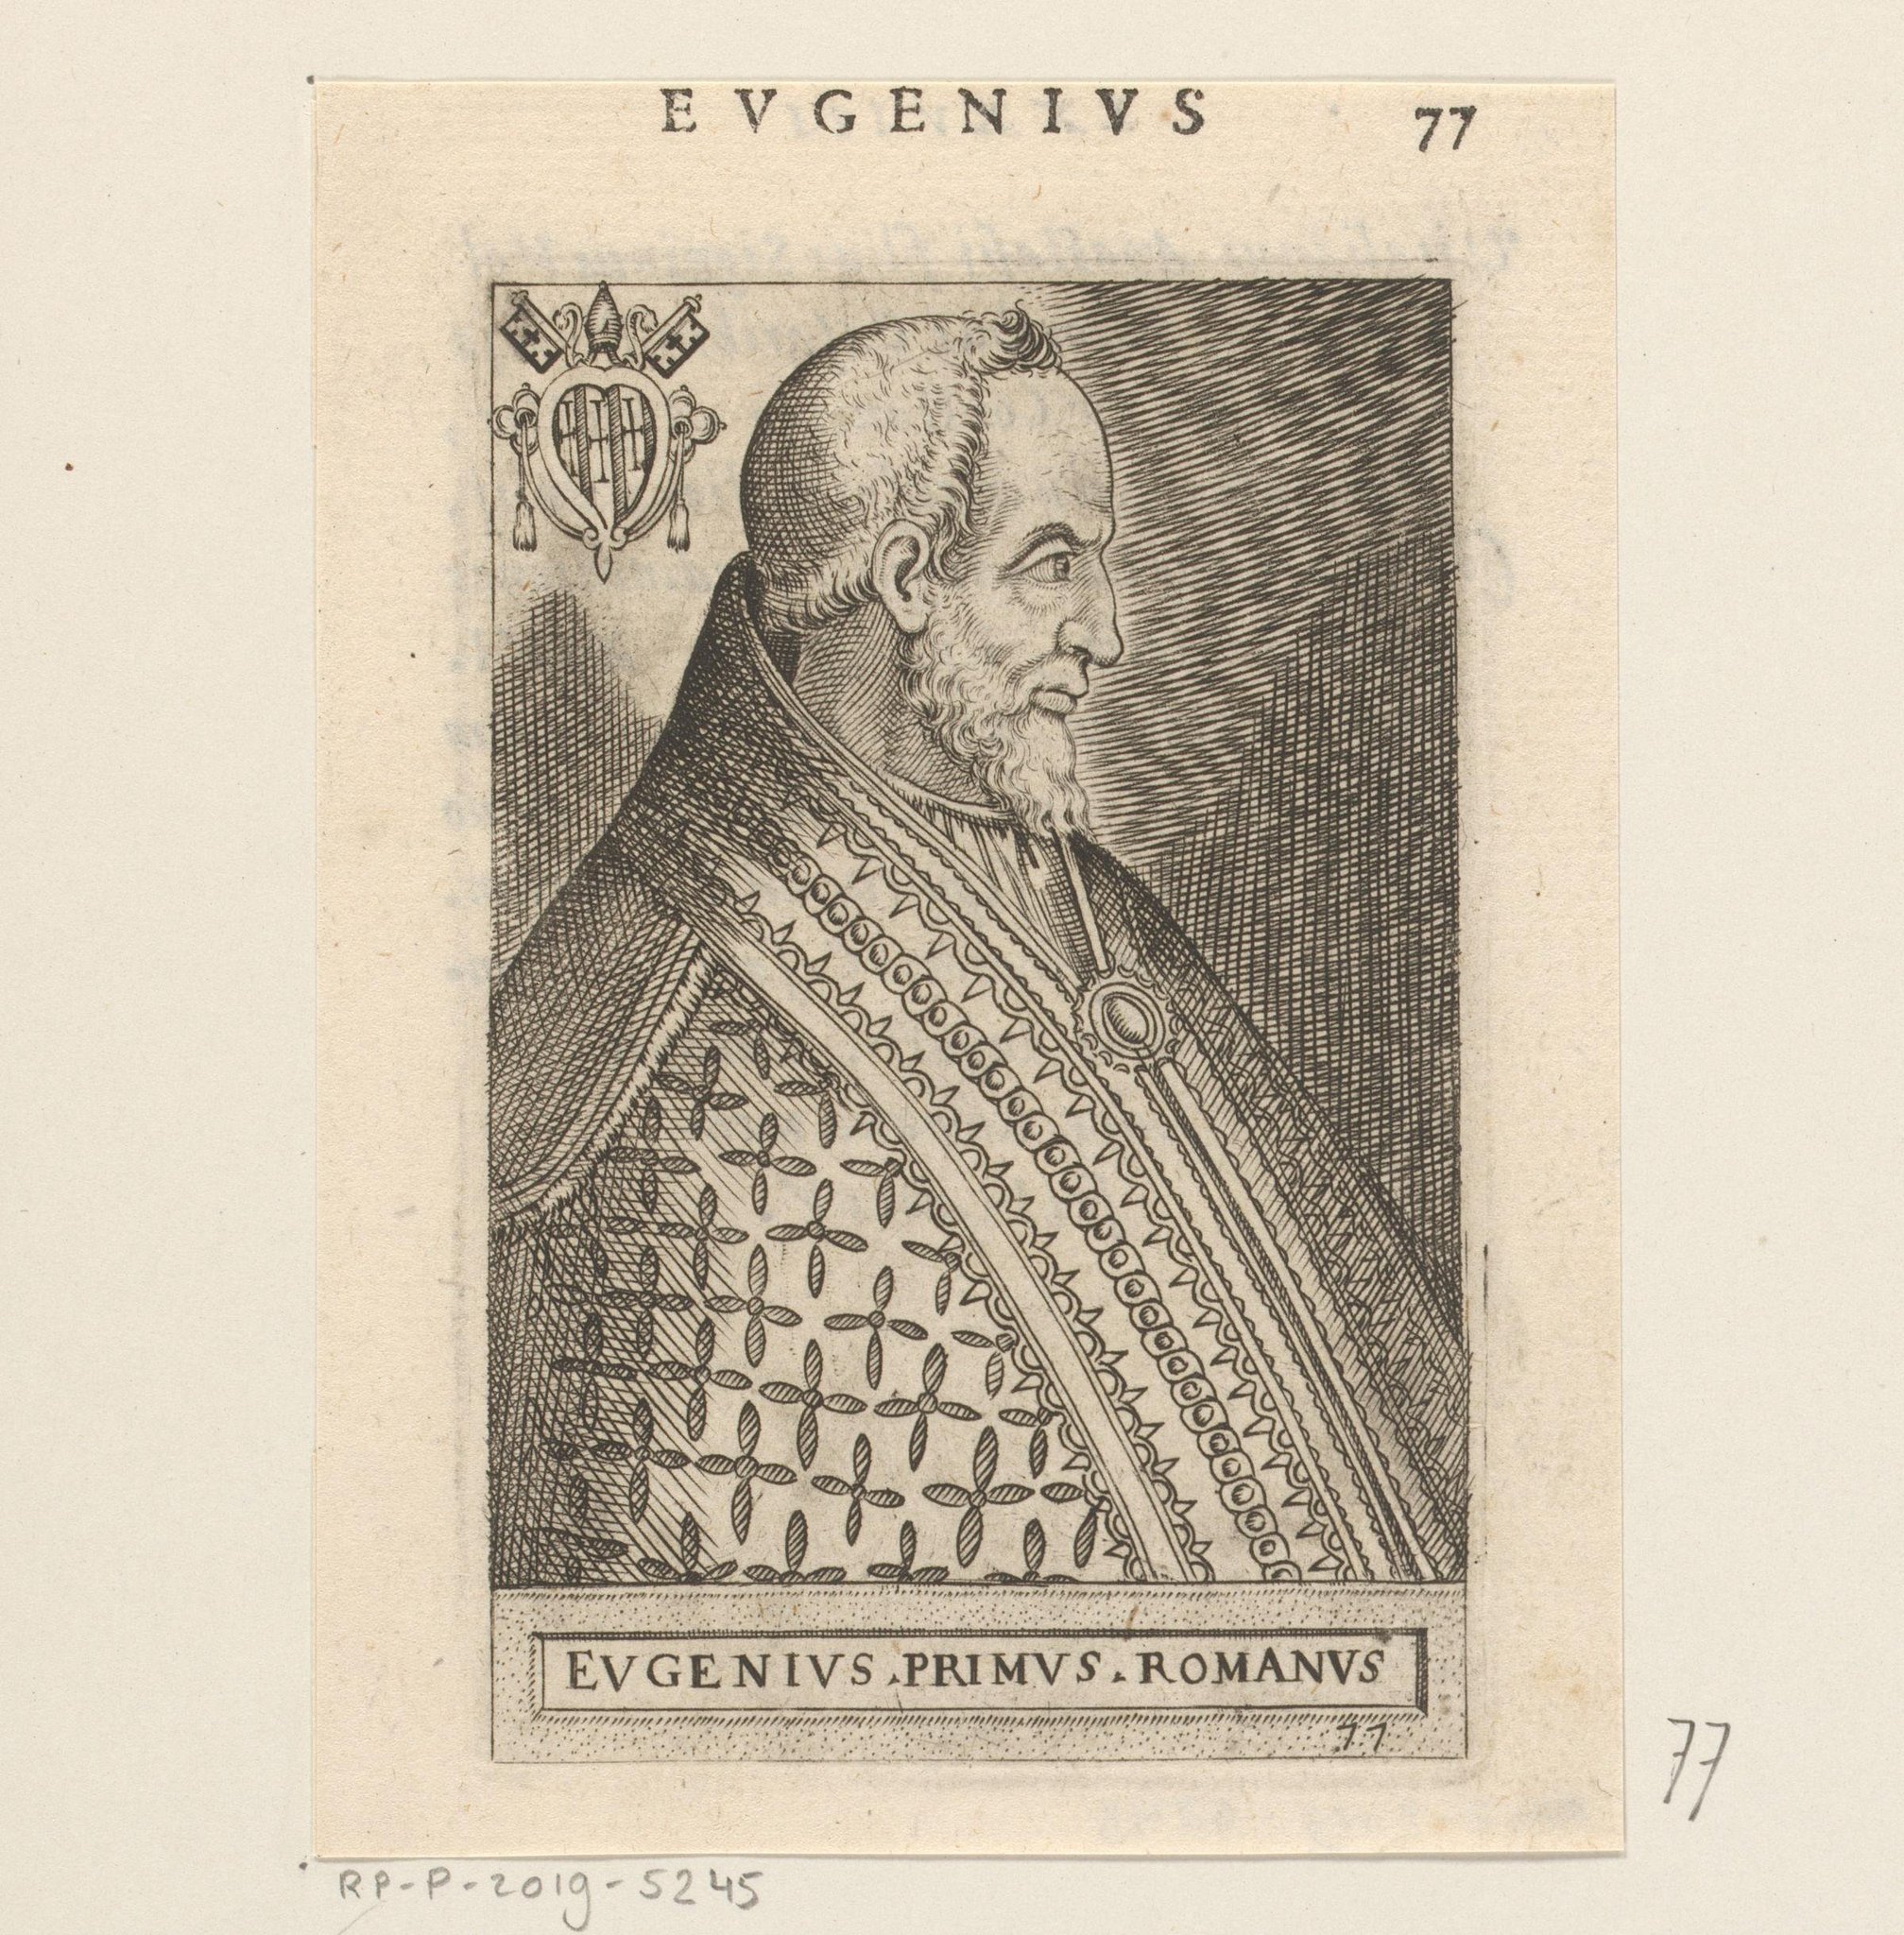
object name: print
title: Portret van paus Eugenius I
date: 1595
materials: paper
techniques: engraving, letterpress printing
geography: rome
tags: historical persons, pope, armorial bearing, heraldry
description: Prent uit: Cavalieri, Giovanni Battista de'. Effigies pontificum romanorum cum eorum vitis (...). Rome: Bartolomeo Bonfadino, 1595. Prent voor het eerst verschenen in: Cavalieri, Giovanni Battista de'. Pontificum romanorum effigies (...). Rome: Domenico Basa en Francesco Zanetti, 1580. Prent ook gebruikt in latere publicaties.